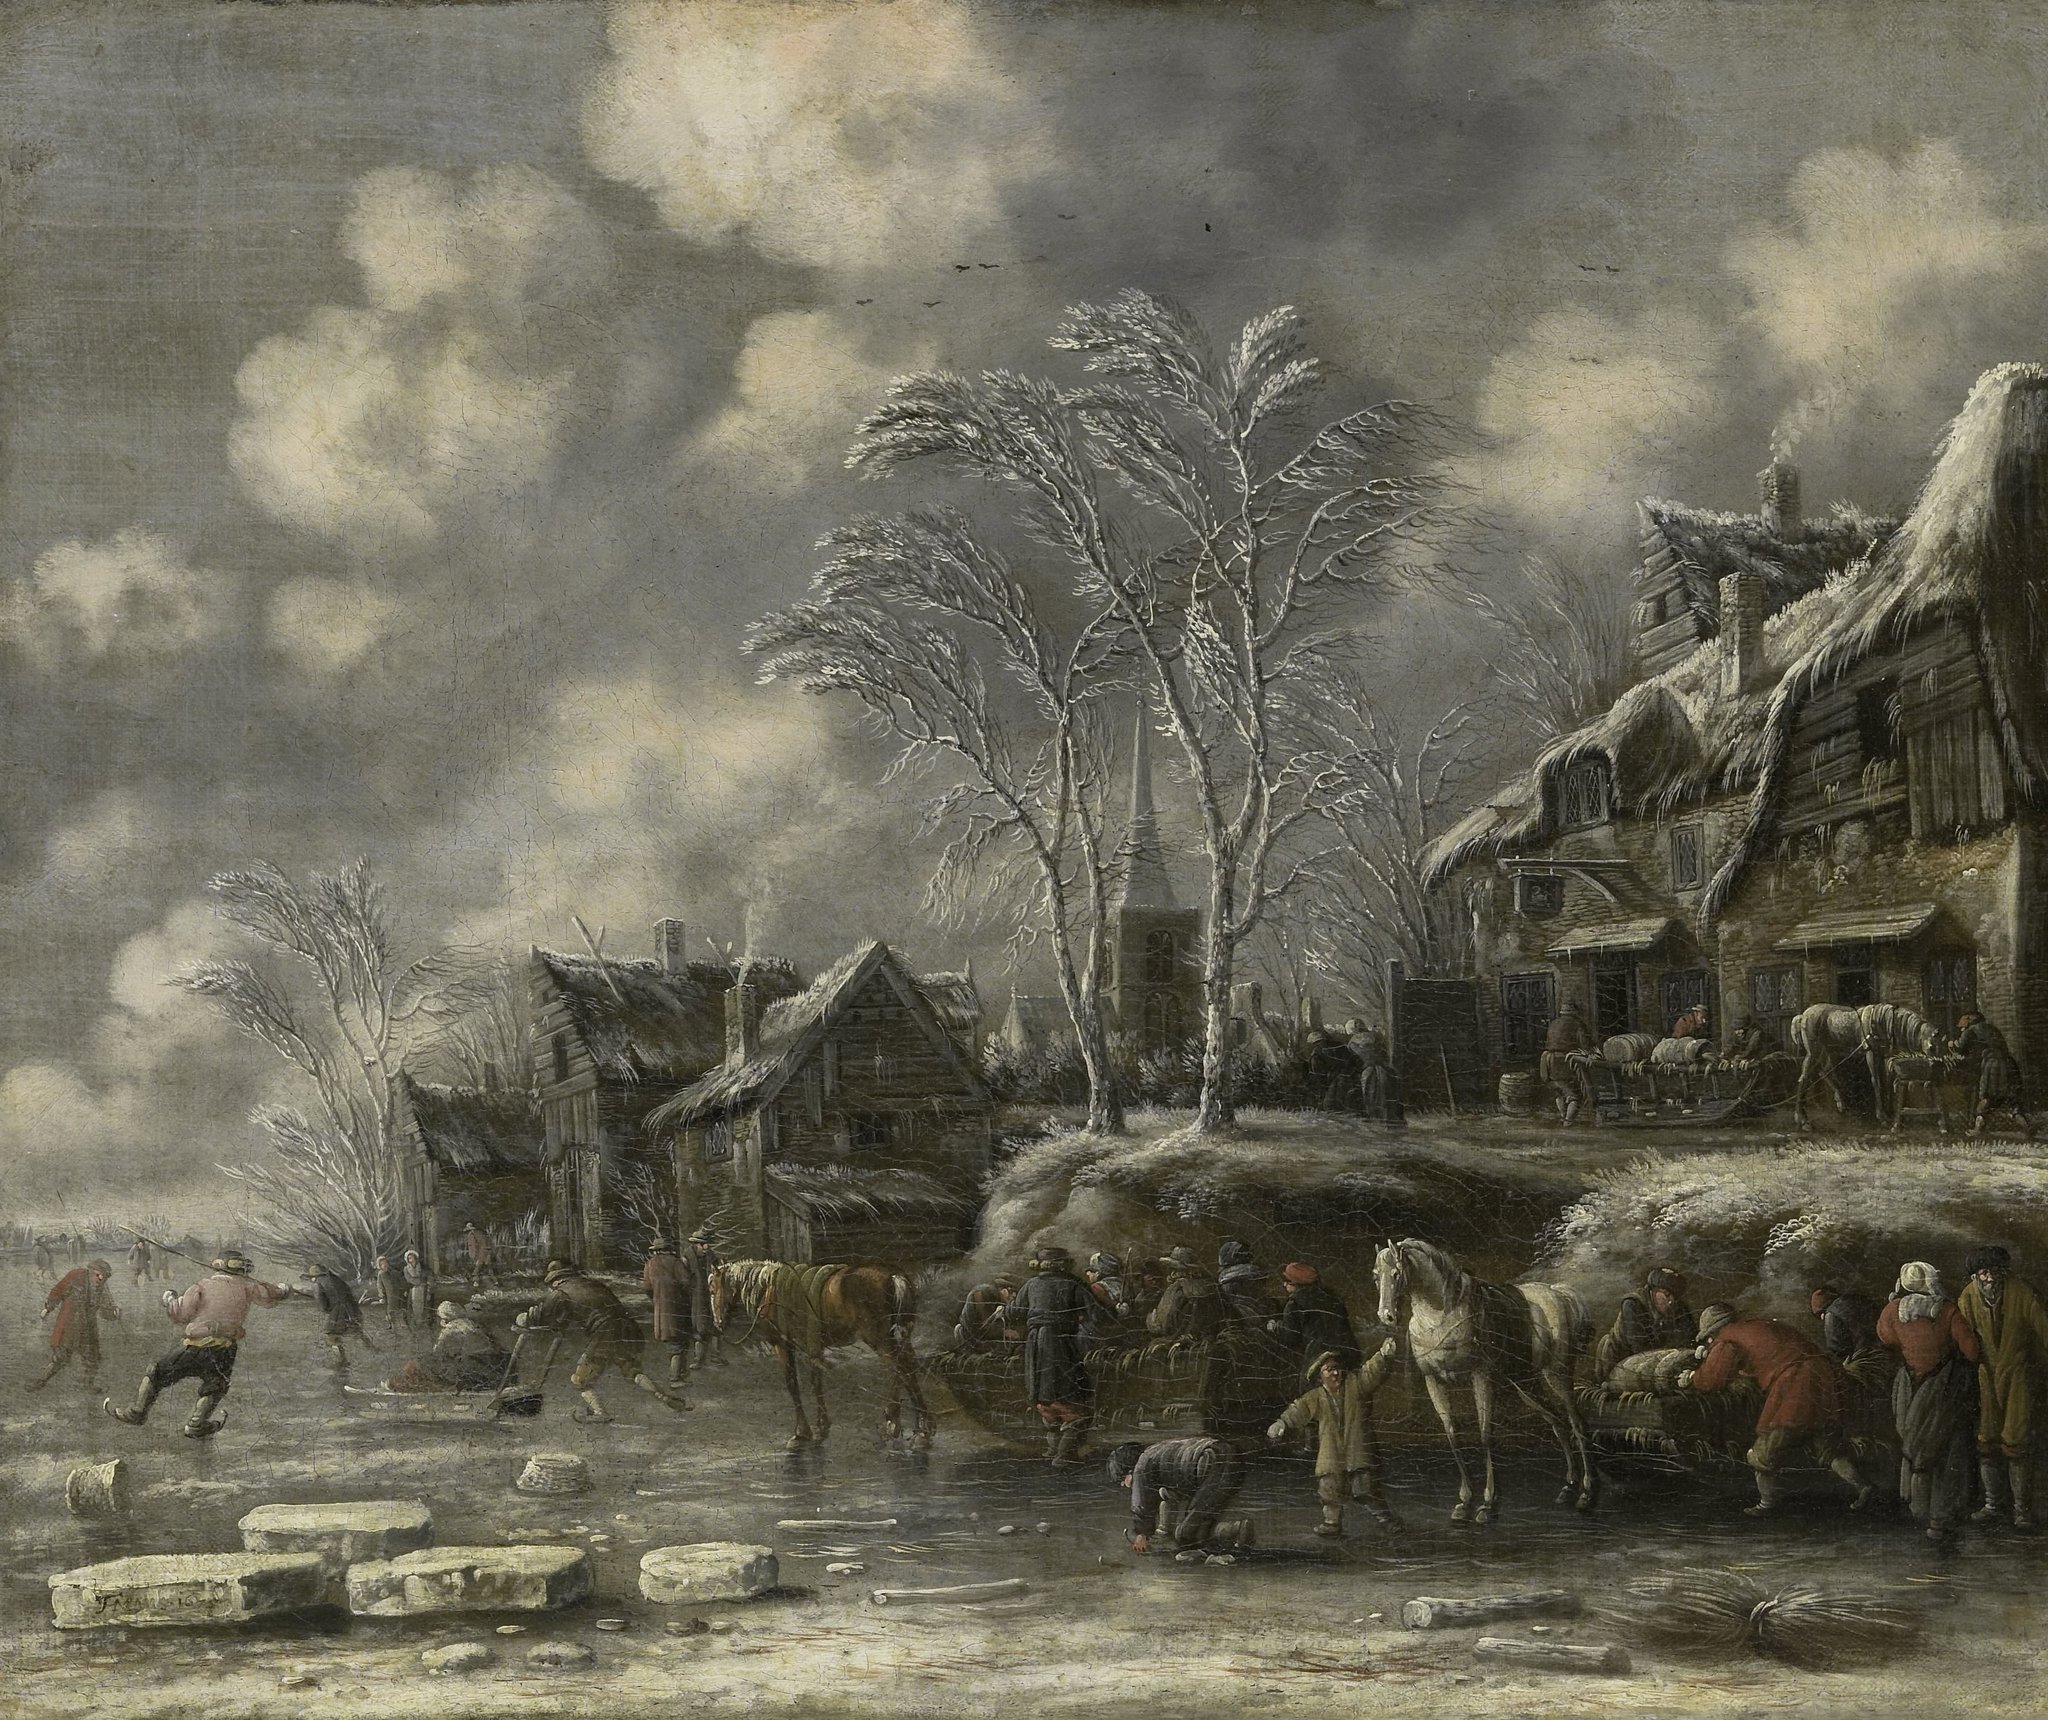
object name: painting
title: Winter Scene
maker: thomas heeremans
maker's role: draughtsman, painter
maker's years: 1641-1702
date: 1675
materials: canvas, oil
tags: frost, freezing weather, horse-sleigh, winter landscape; landscape symbolizing winter (the four seasons of the year), skates (winter sports)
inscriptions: signature and date: ‘THMans 1675’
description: Wintergezicht. Schaatsers en sleden op het ijs bij een dorp. In het midden een grote slede voor het vervoer van personen, getrokken door een paard. Rechts een slede waarop vaten worden geladen.